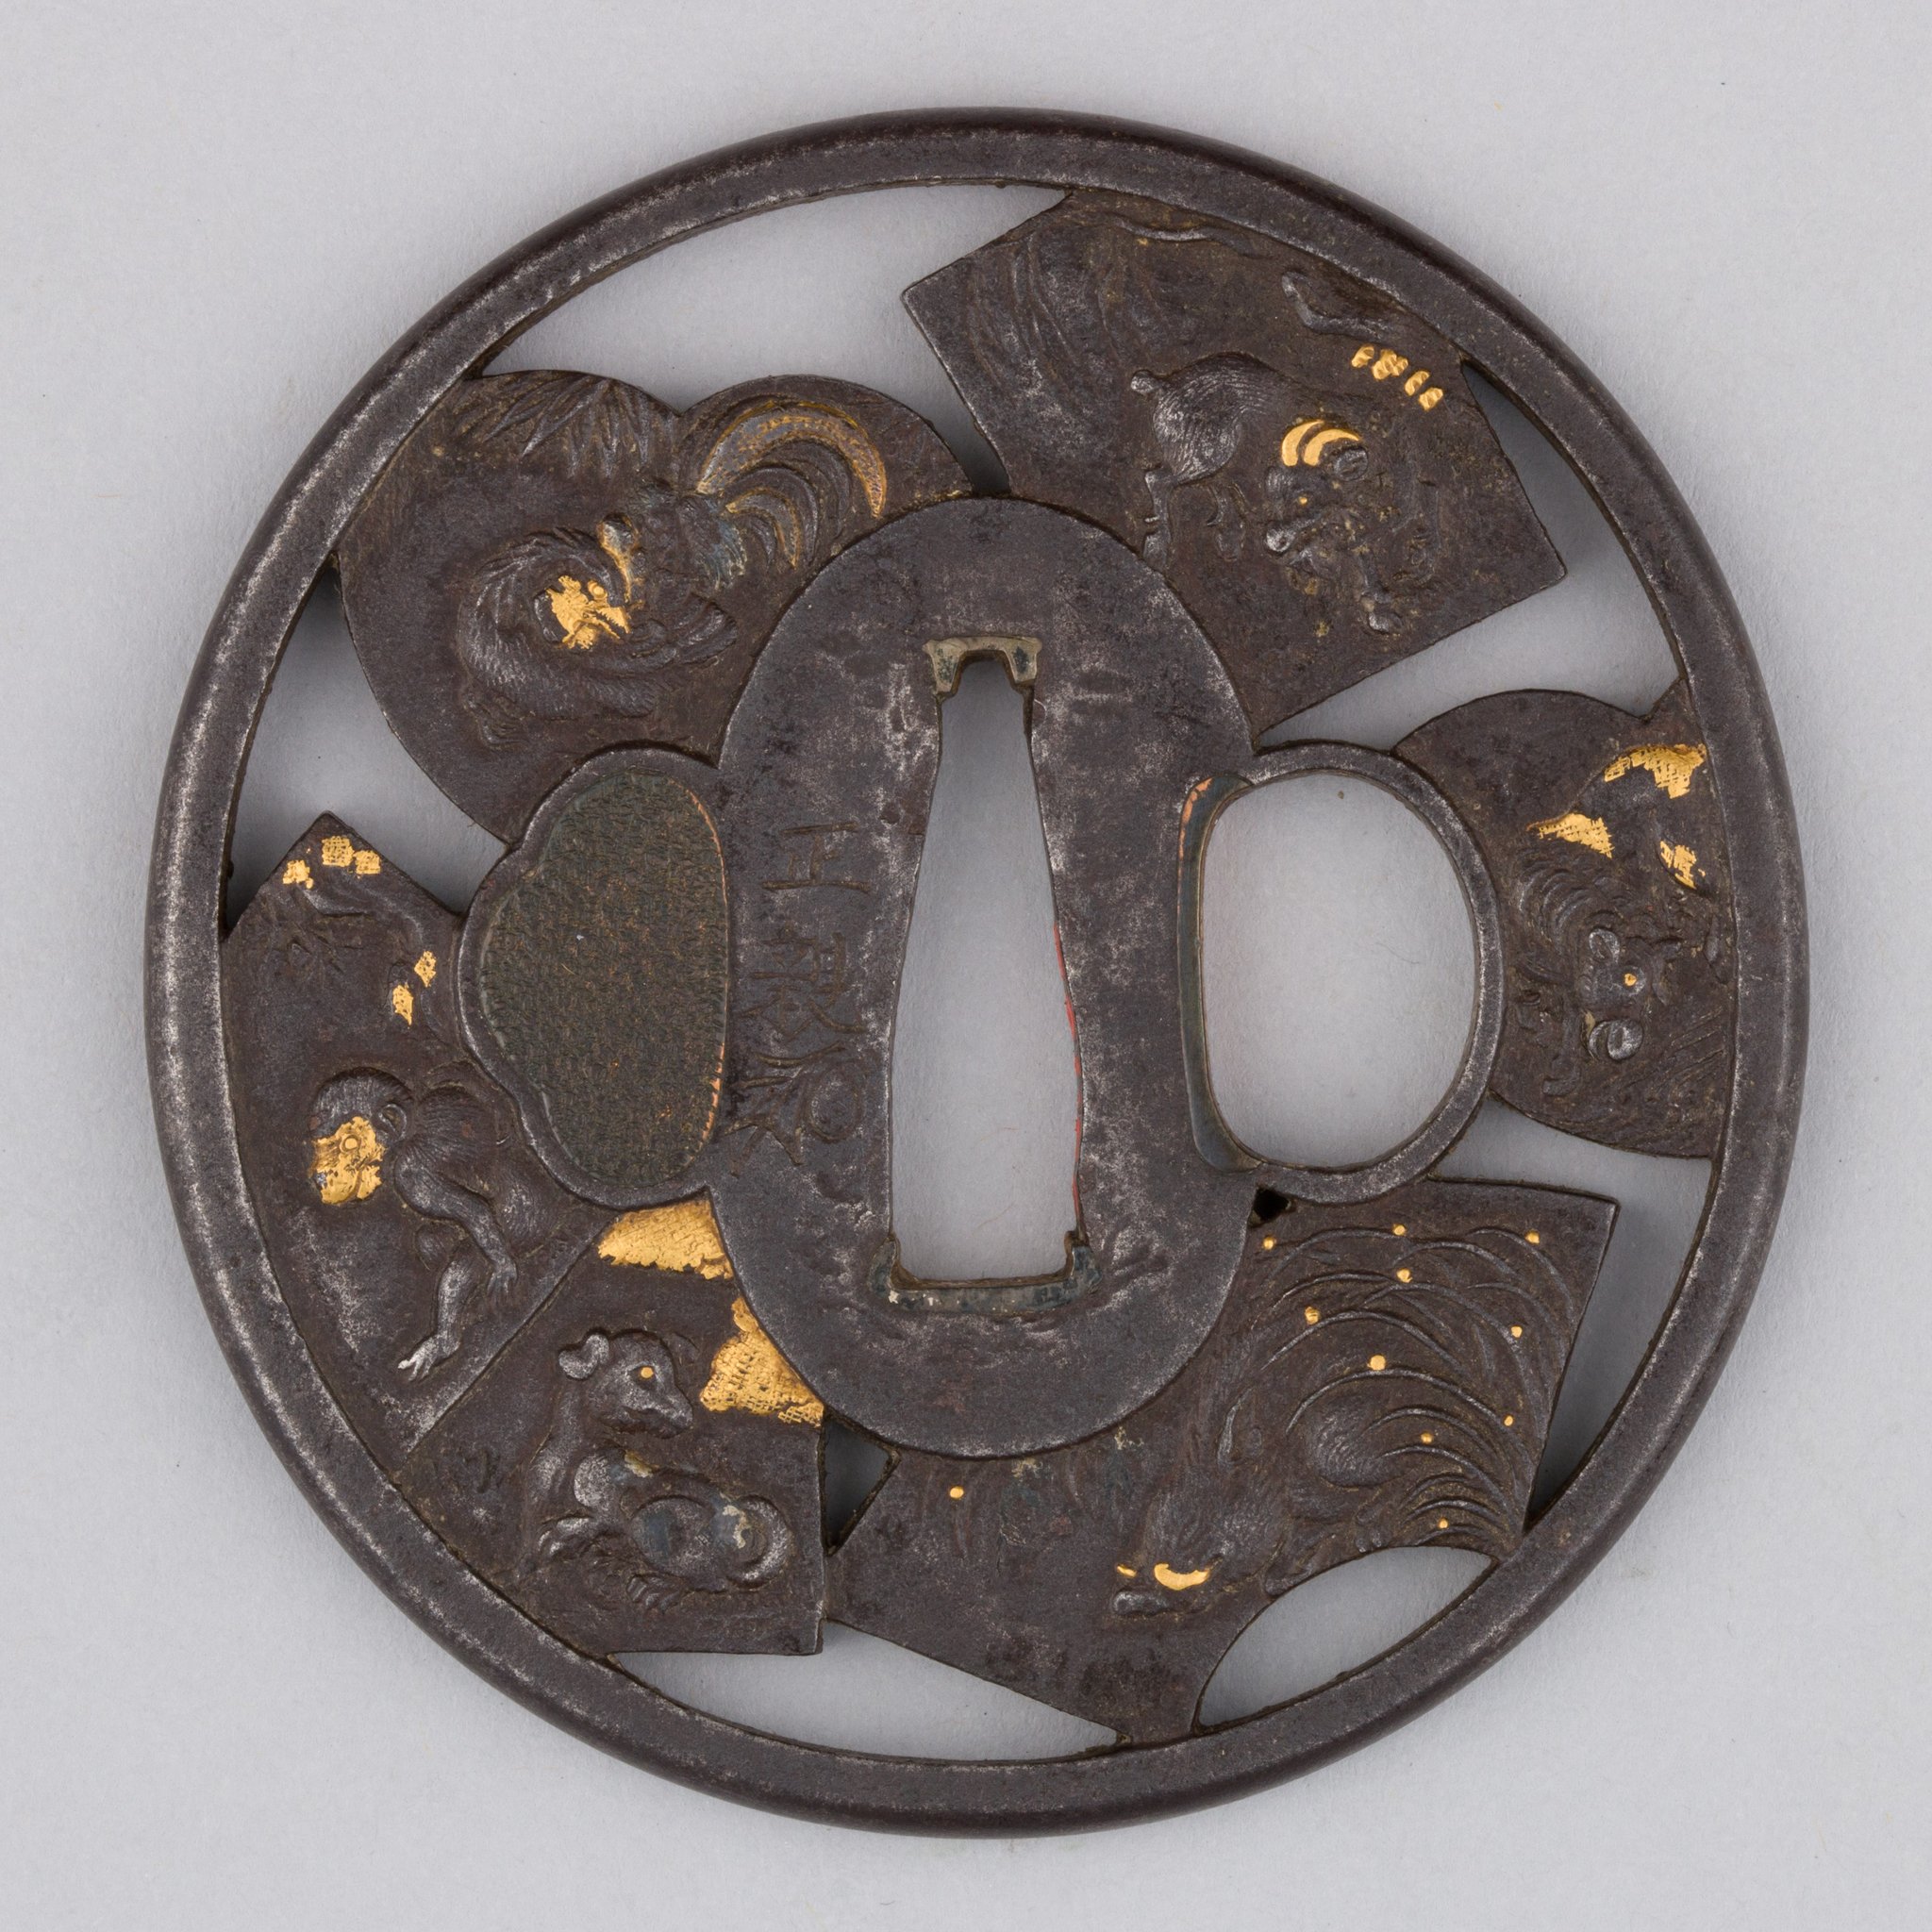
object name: sword guard tsuba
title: Sword Guard (Tsuba)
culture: japanese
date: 1701-1800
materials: copper, gold, iron, silver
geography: japan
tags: dragons,roosters,dogs,monkeys,rabbits,snakes,tigers,zodiac,ox